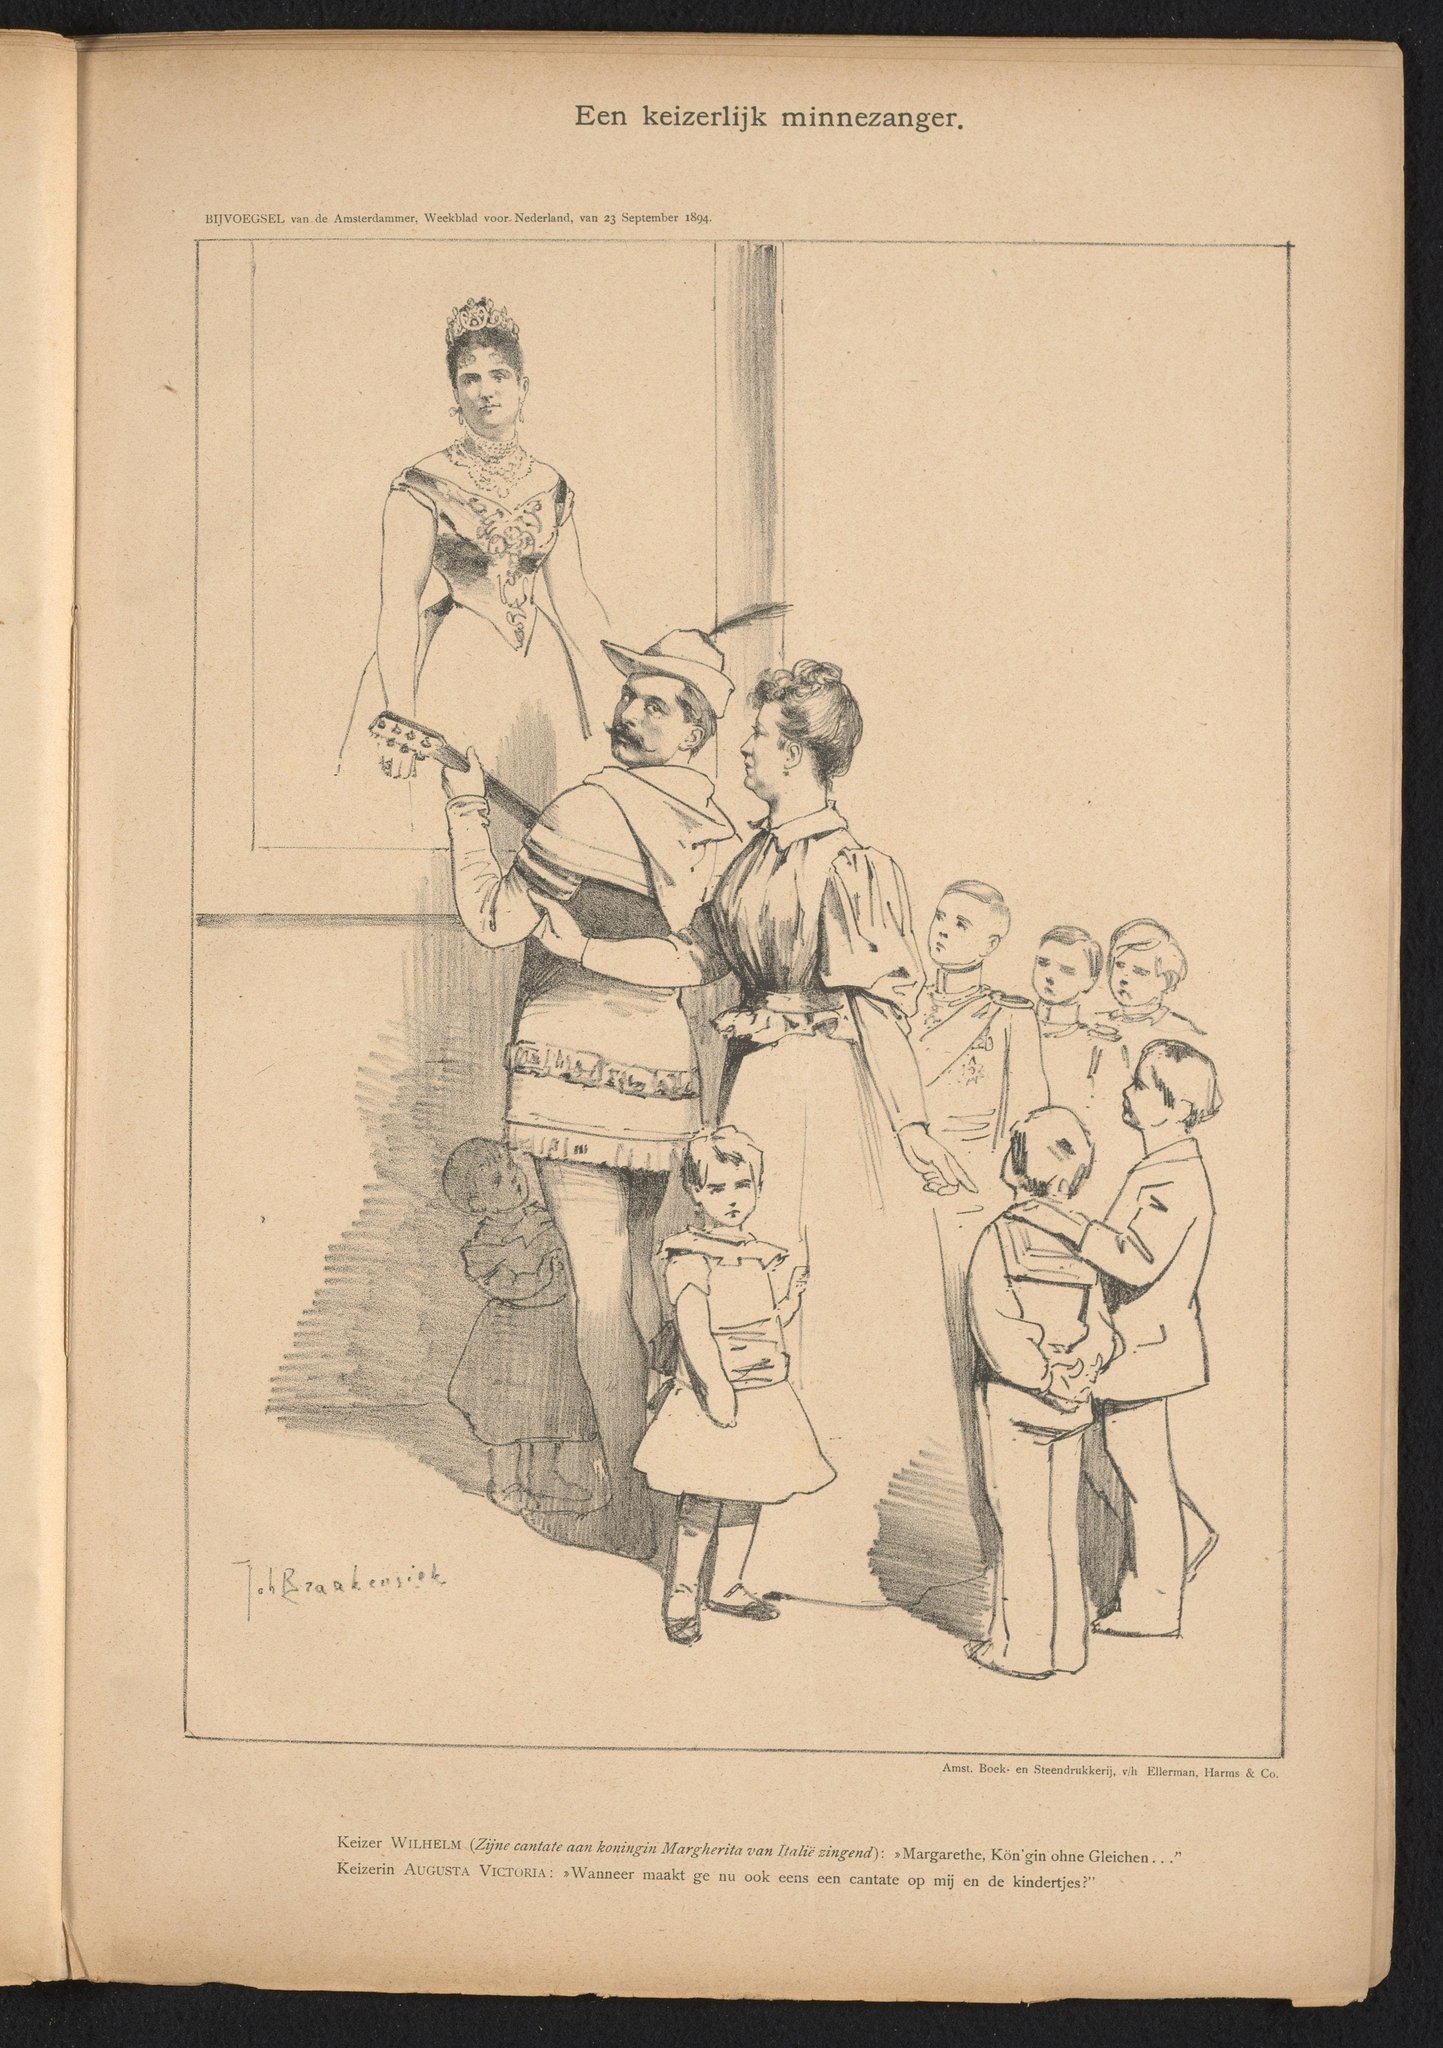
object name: cartoon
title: Een keizerlijk minnezanger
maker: johan braakensiek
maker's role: draughtsman, print maker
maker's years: 1858-1940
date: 1894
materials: paper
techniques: lithograph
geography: netherlands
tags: wilhelm ii (keizer van duitsland), augusta victoria (keizerin van duitsland), family group, especially parents with their child(ren), the envious friends; criticizing bystanders ~ love couple, political caricatures and satires, serenade to the beloved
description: De Duitse keizer Wilhelm II brengt een serenade aan de Italiaanse koningin Margaretha van Savoye. Tot ongenoegen van zijn echtgenote keizerin Augusta Victoria en het hele gezin.